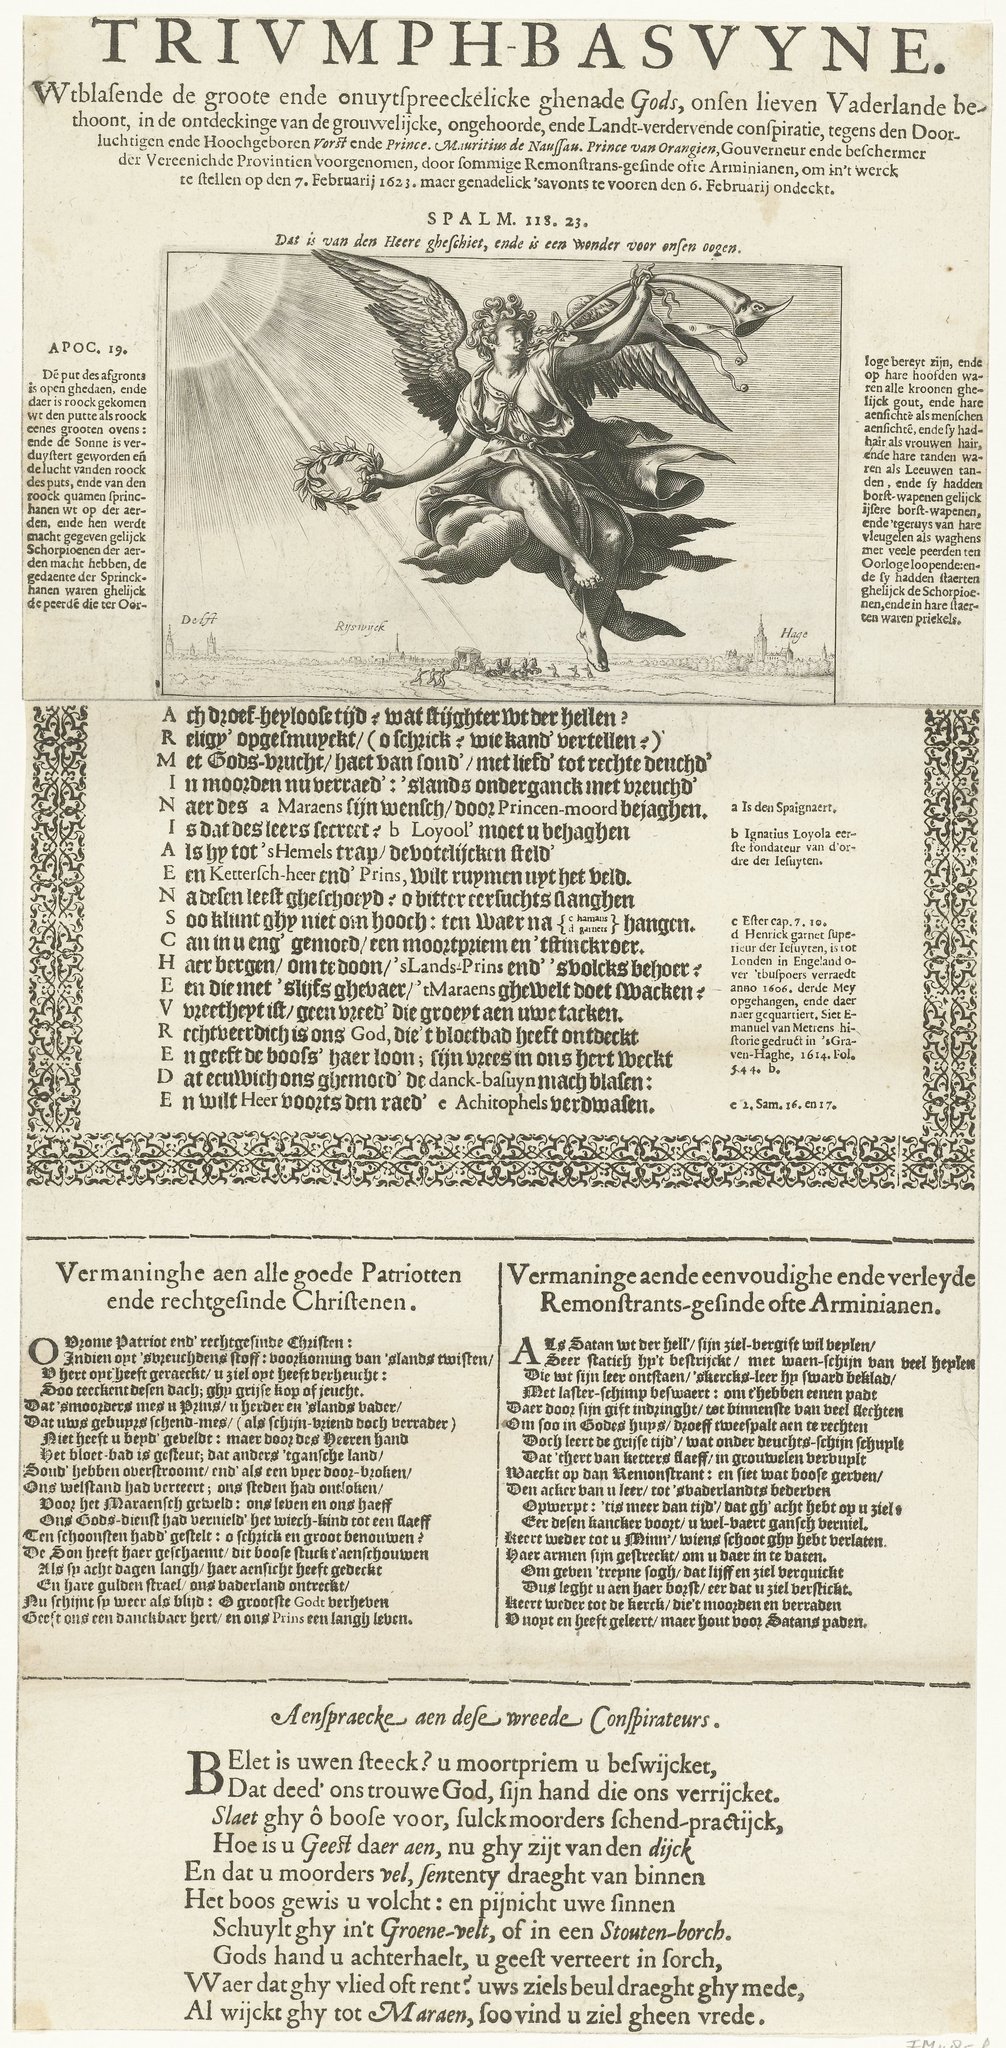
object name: print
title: Triumphbasuyne. Wtblasende de groote ende onuytspreeckelicke ghenade Gods, onsen lieven Vaderlande bethoont, in de ontdeckinge van de grouwelijcke (...) conspiratie tegens (...) Prince Mauritius de Naussau (...) den 6. Februarij ondeckt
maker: Anonymous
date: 1623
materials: paper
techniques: engraving, letterpress printing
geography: northern netherlands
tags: the hague, maurice (prince of orange), (revolutionary) plot, conspiracy, fame; 'fama', 'fama buona', 'fama chiara' (ripa)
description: Allegorie op de ontdekking van de samenzwering tegen Maurits, 1623. Faam in de lucht met lauwerkrans en bazuin vliegend boven het land waarin Delft, Rijswijk en Den Haag zijn aangeduid. Aan weerszijden van de prent een bijbelcitaat uit de Apocalypse. Op een blad gecombineerd met verschillende teksten, verzen en vermaningen.